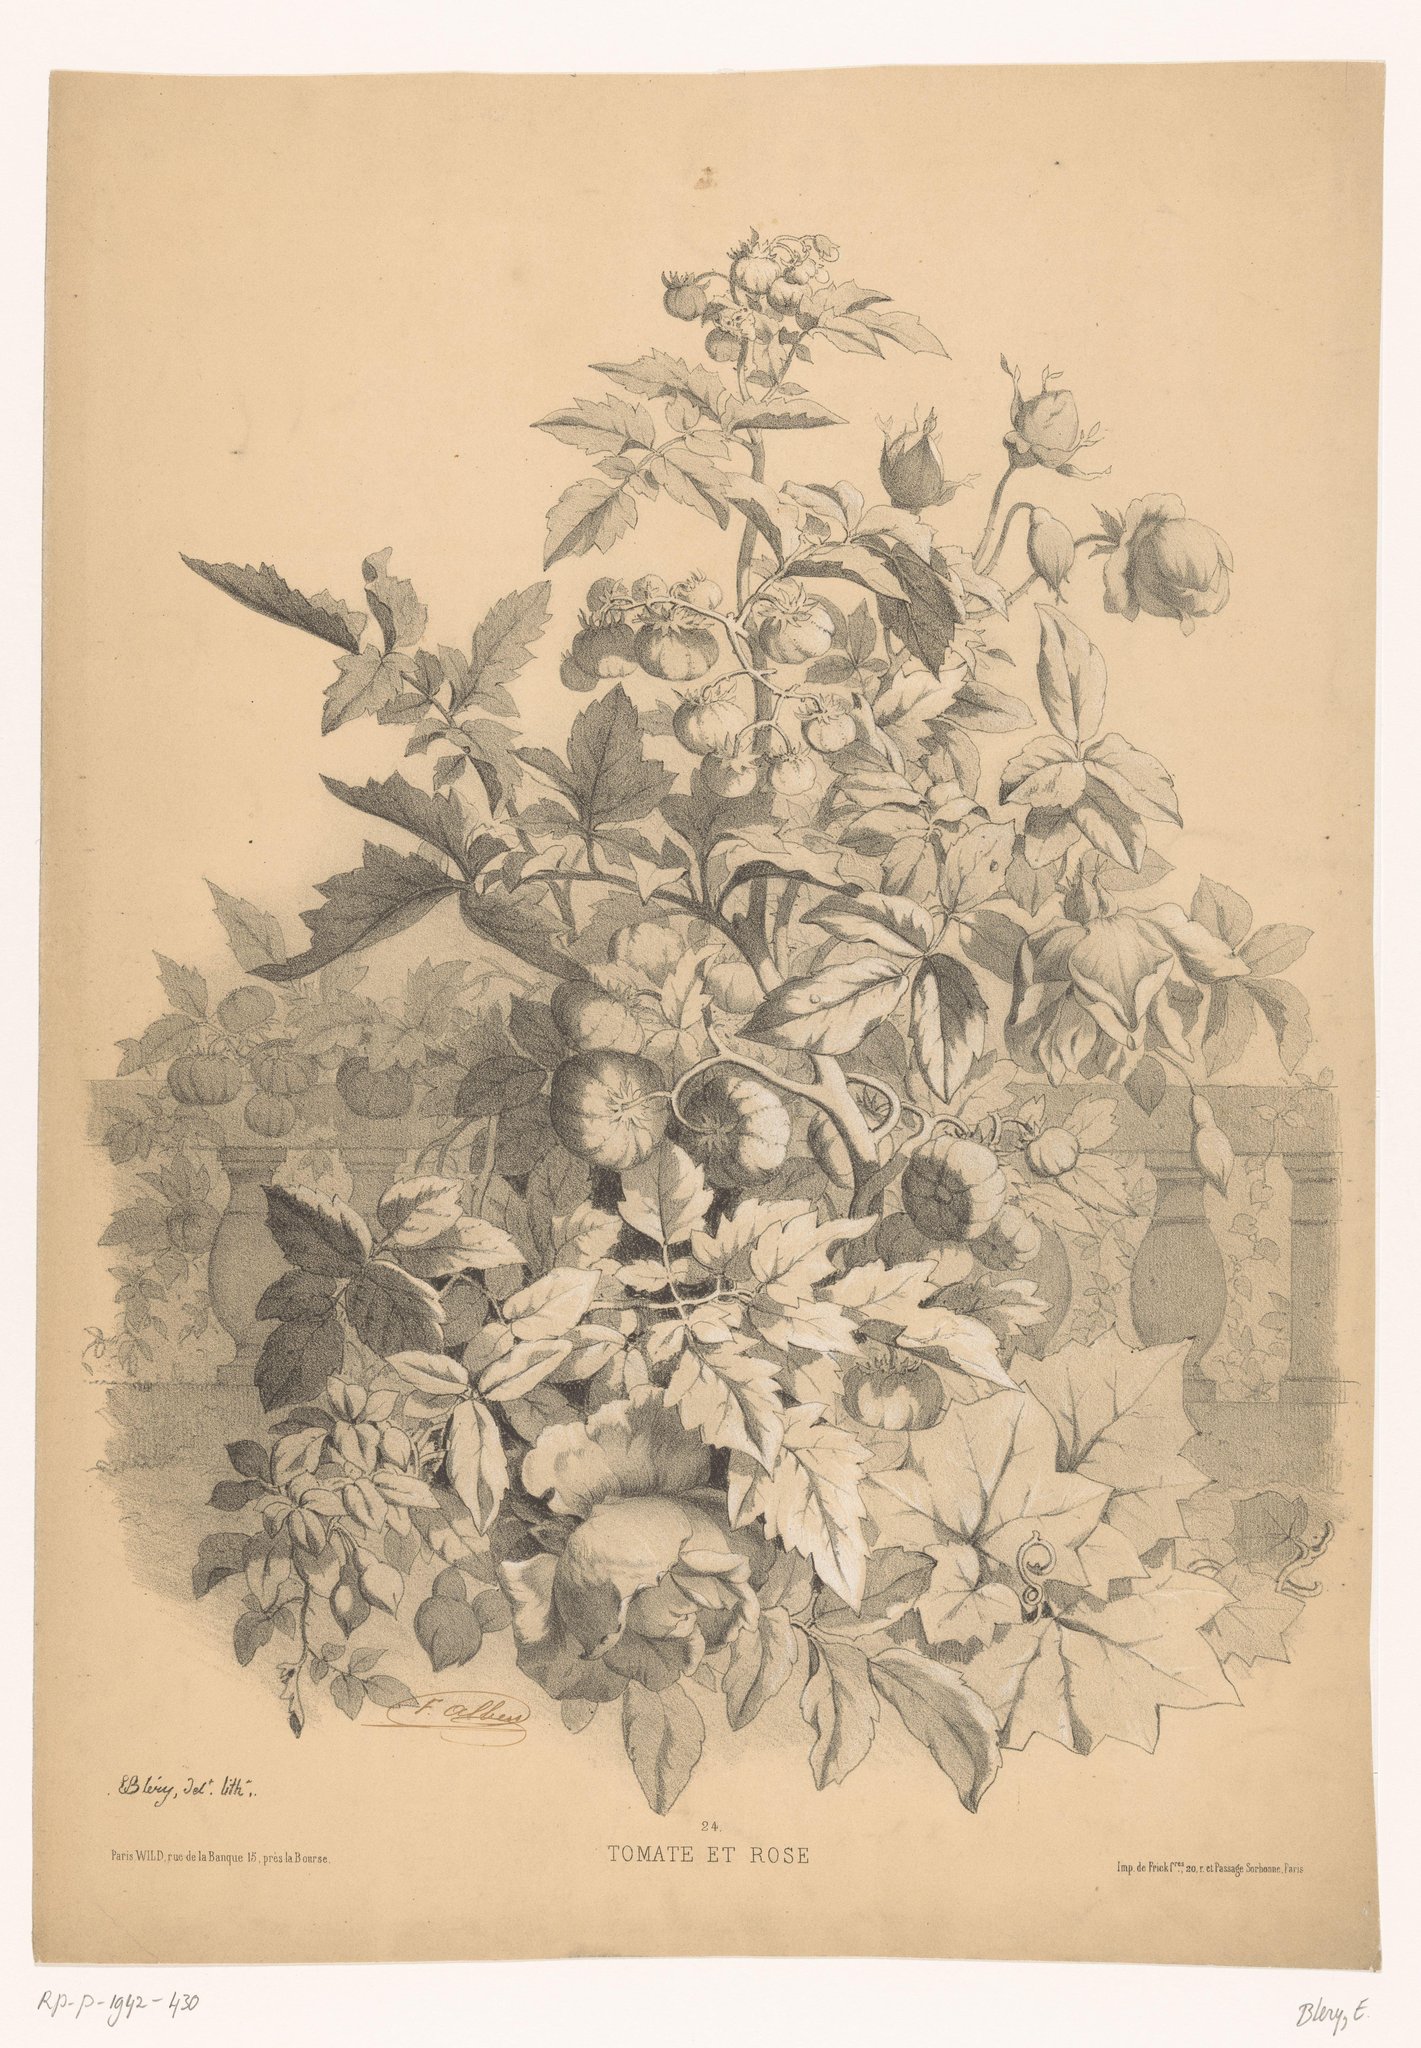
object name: print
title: Tomate et rose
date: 1858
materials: paper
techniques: tone lithography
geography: paris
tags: flowers: rose, plants and herbs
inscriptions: collector's mark: Lugt 2228, annotation: ‘F. Albers’, collector's mark: Lugt 2760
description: De serie Guide industriel dessiné d'après nature et lithographié par Bléry is uitgegeven in verschillende livraisons tussen 1853 en 1858.